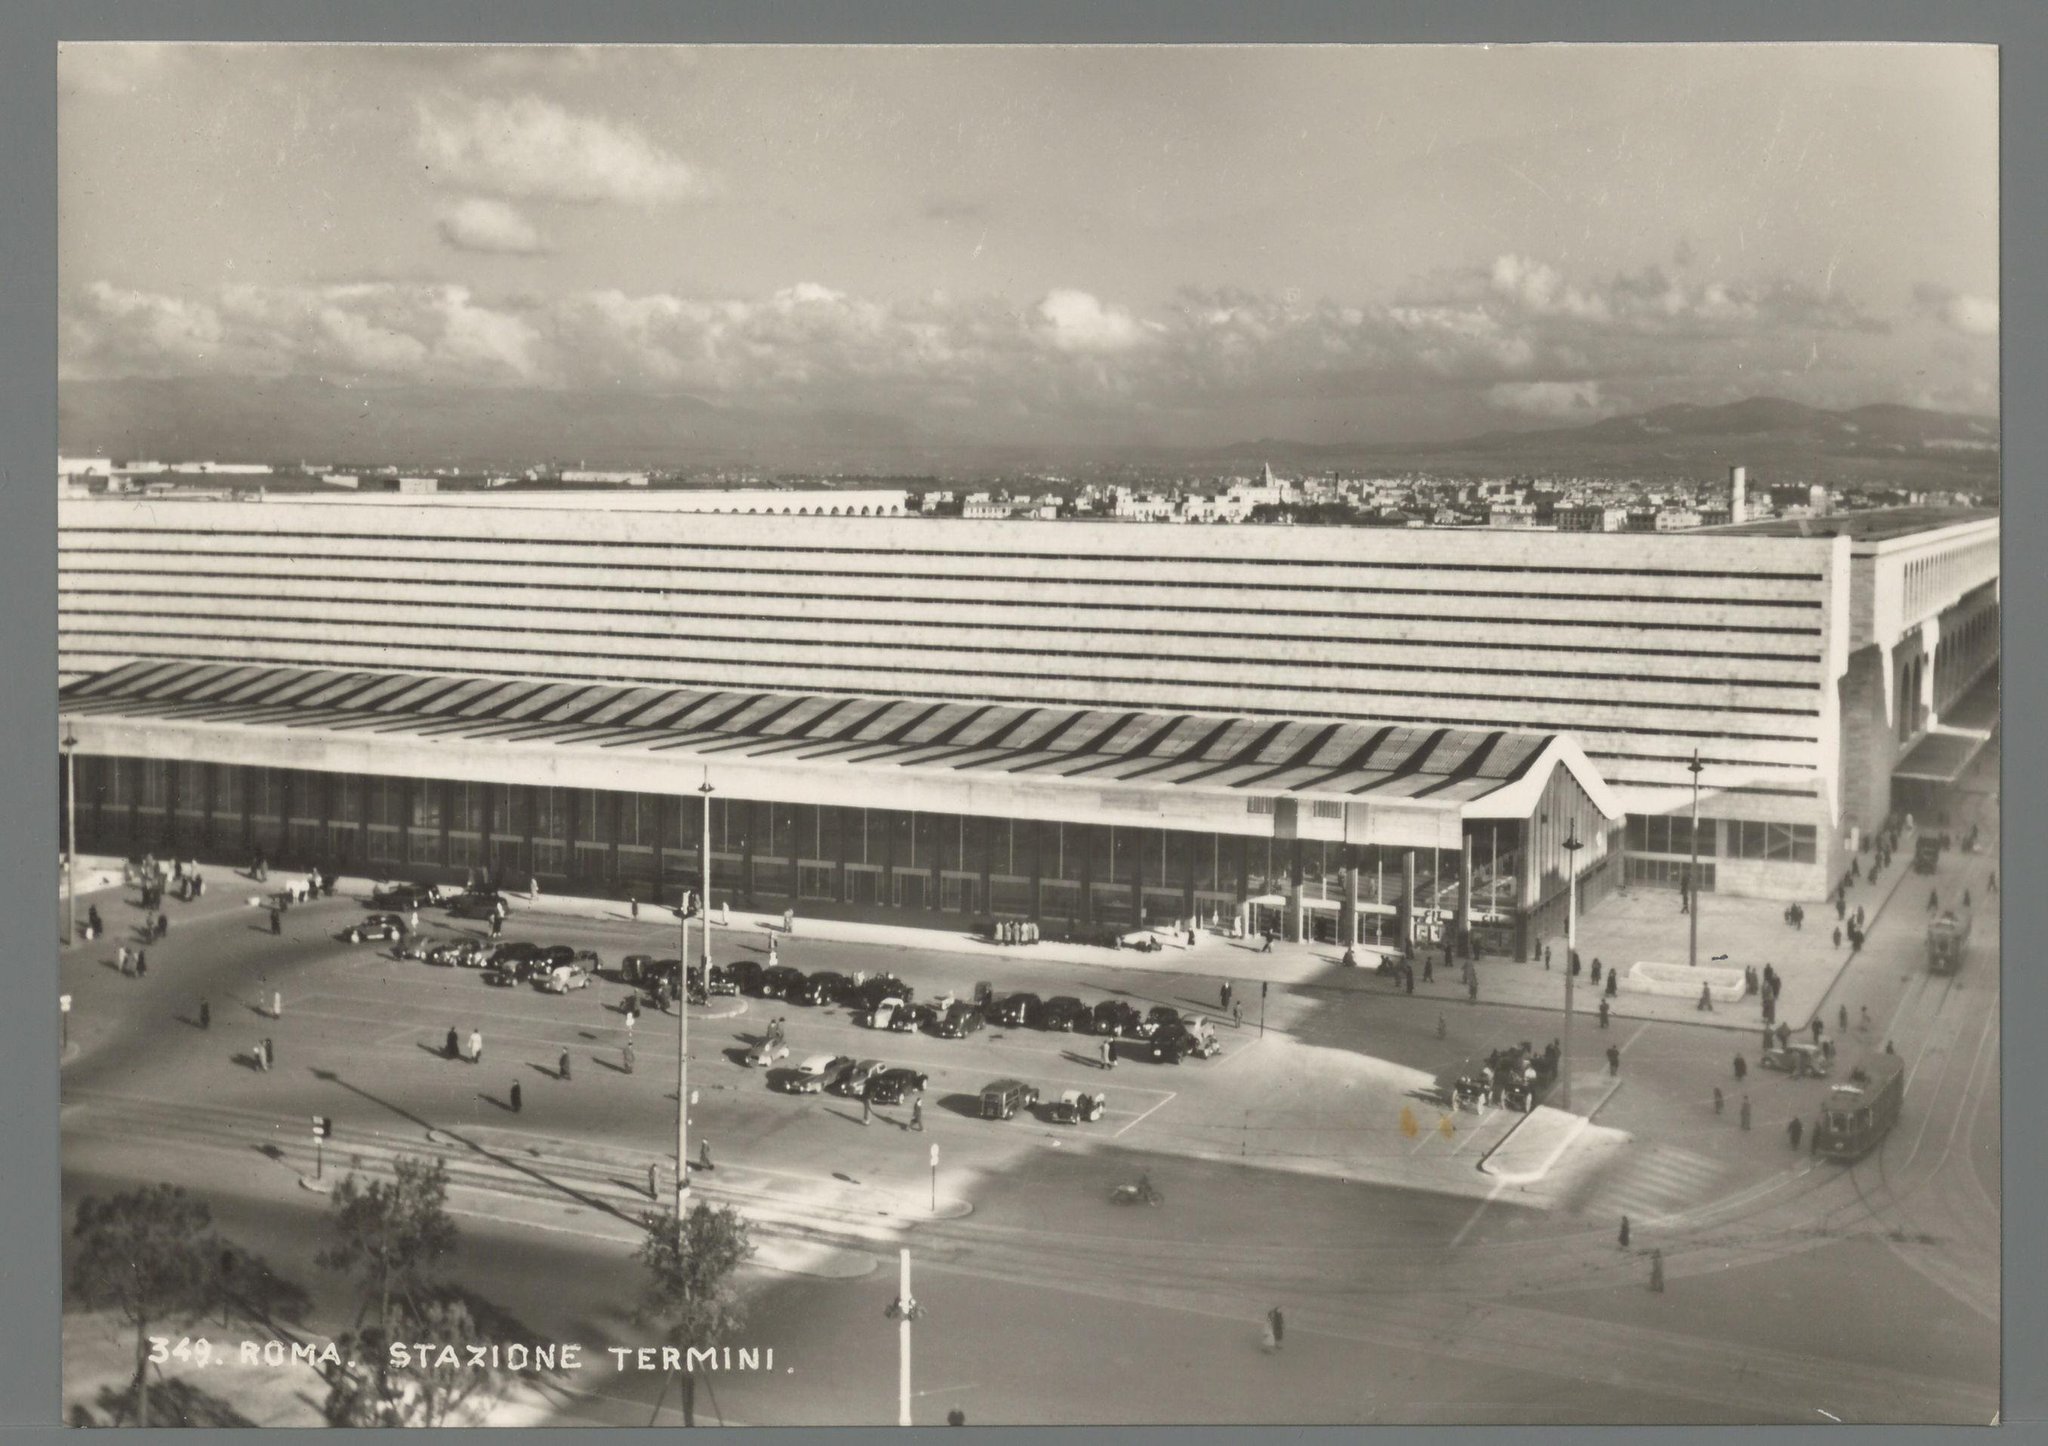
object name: photograph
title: Roma. Stazione Termini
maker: Anonymous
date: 1950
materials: photographic support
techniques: photography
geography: rome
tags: station; shelter (railway, tramway), city-view, and landscape with man-made constructions (+ city(-scape) with figures, staffage), rome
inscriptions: signature: ‘Ed. P. Chauffourier/ Via Federico Confalonieri, 1- Roma’